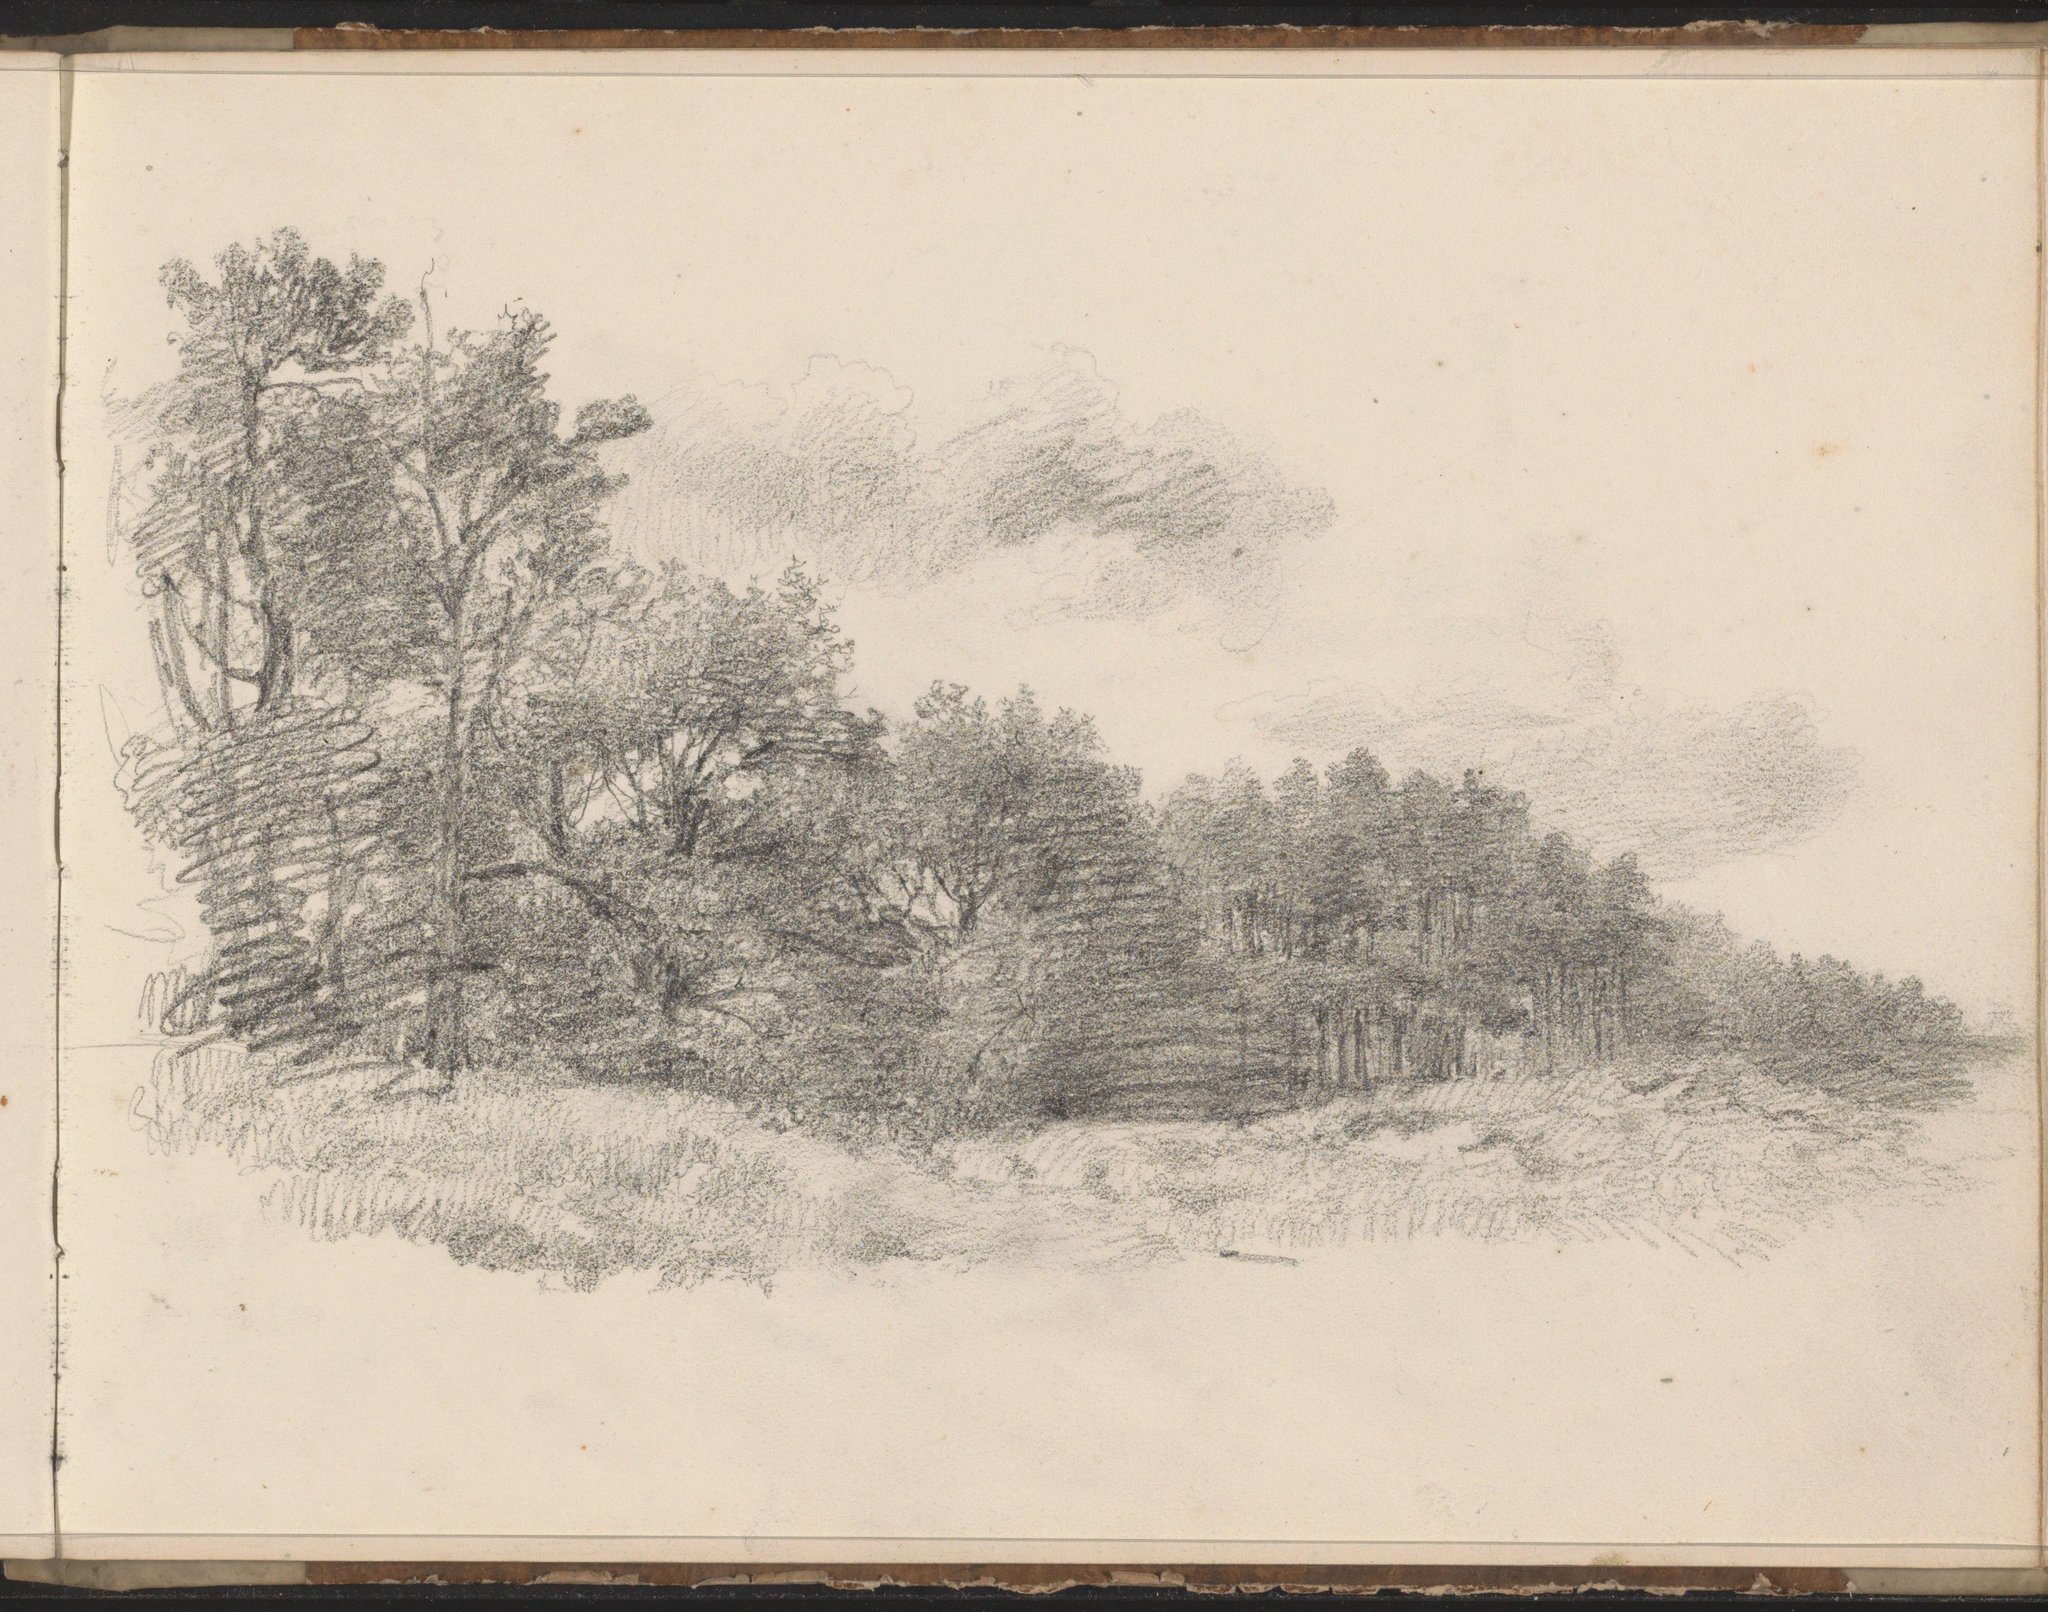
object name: sketchbook leaf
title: Bosrand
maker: maria vos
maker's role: draughtsman, painter, print maker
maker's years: 1824-1906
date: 1834-1906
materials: paper, pencil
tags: forest, wood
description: Blad 32 recto uit een schetsboek met 39 bladen.